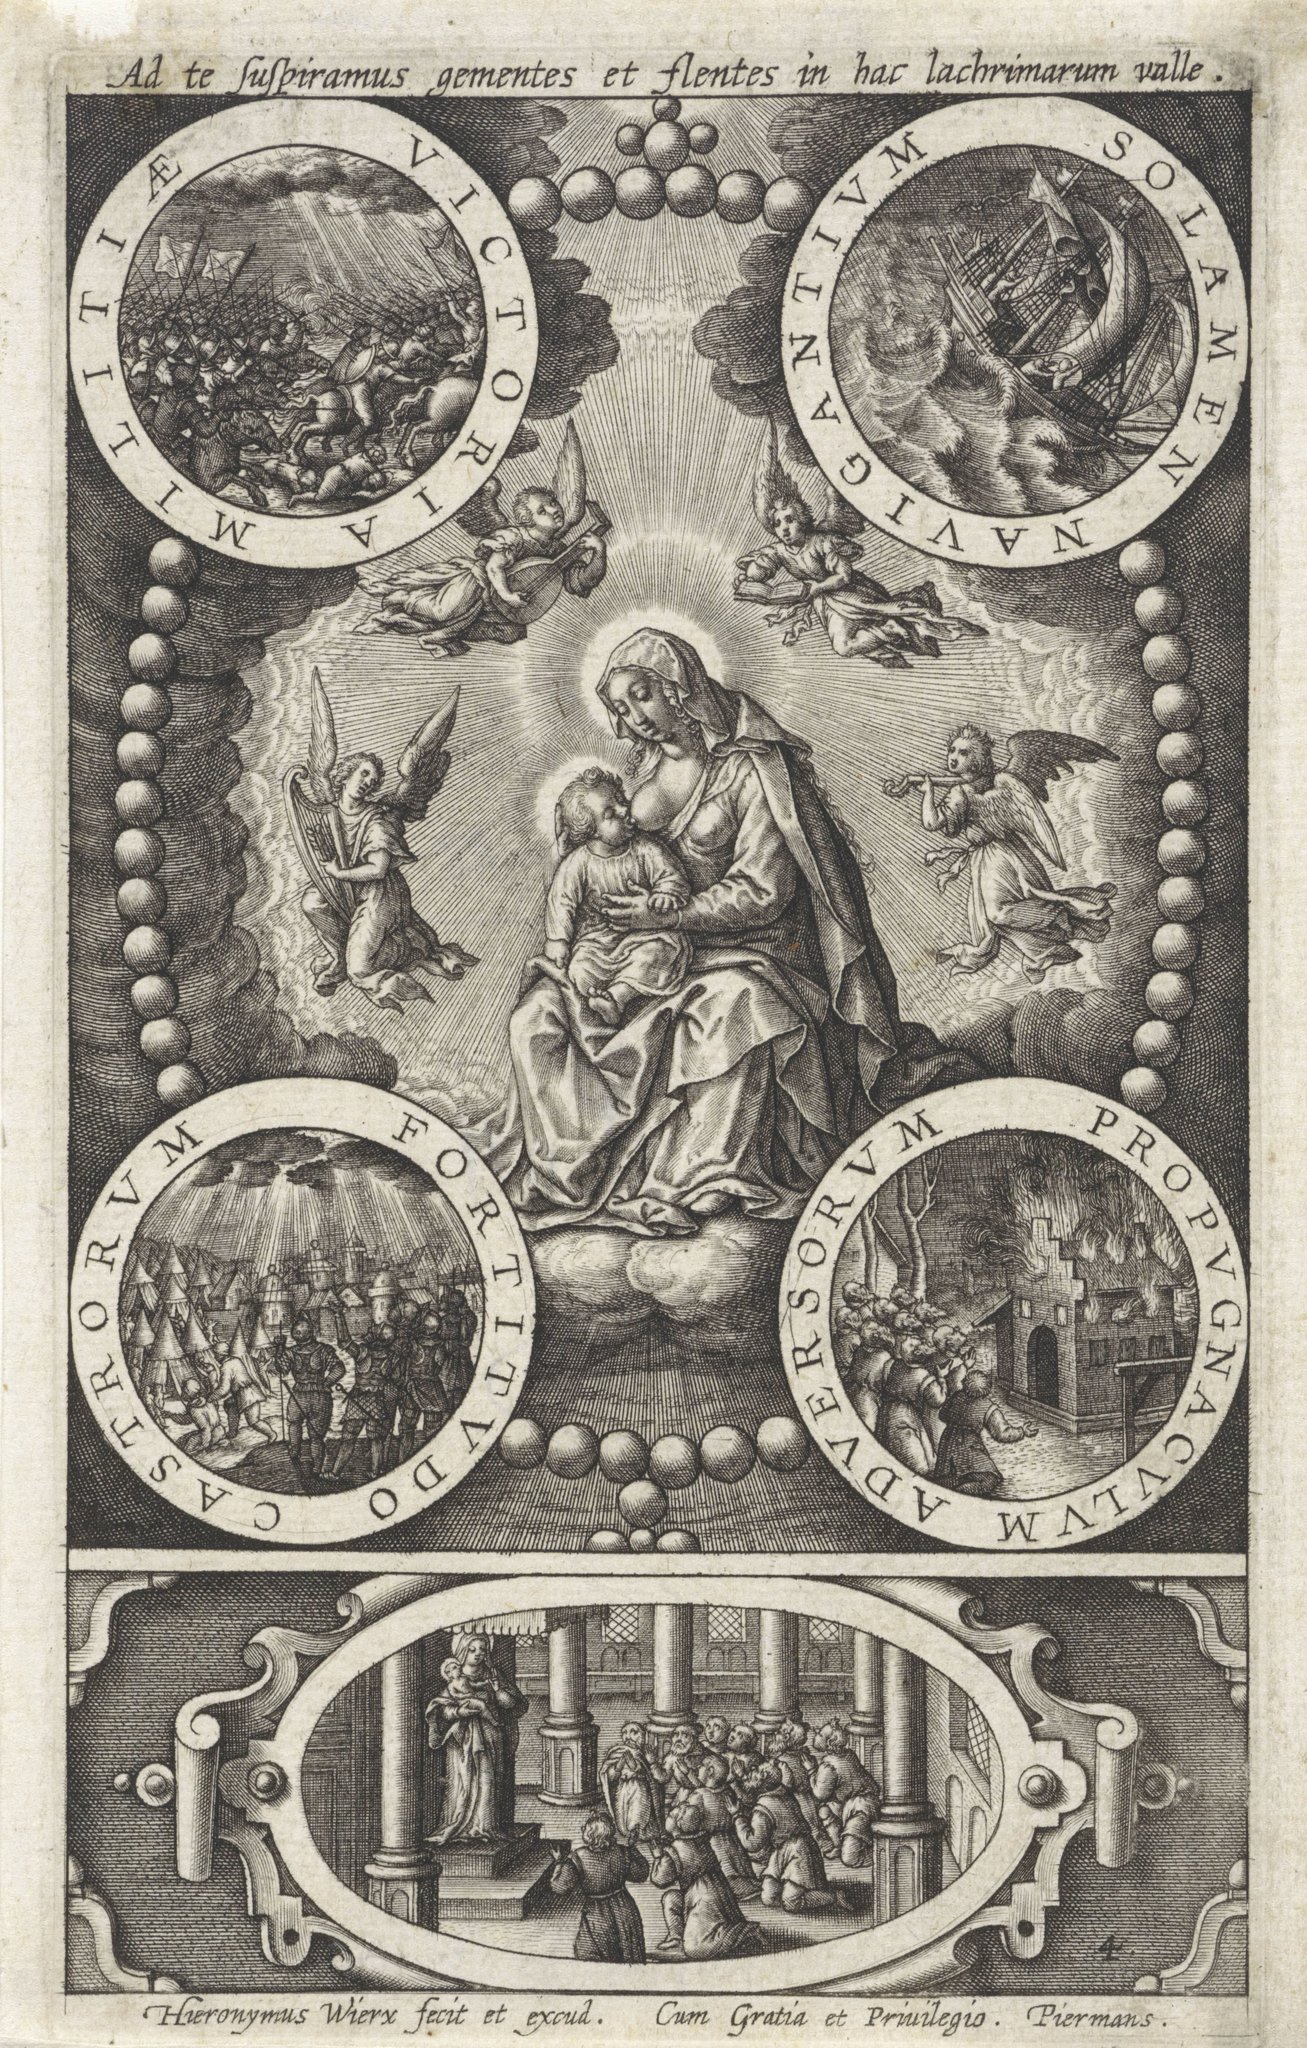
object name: print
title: Maria zoogt het Christuskind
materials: paper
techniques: engraving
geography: antwerp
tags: christ-child suckling, or beginning to suckle, e.g. mary uncovering her breast ~ madonna-representations (+ angel(s)), mary devotion, consoling the sorrowful ~ one of the (seven) spiritual acts of mercy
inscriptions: collector's mark: Lugt 2228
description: Maria zoogt het Christuskind dat bij haar op schoot zit. Ze zijn omringd door musicerende engelen. De voorstelling is gevat in een omlijsting van kralen. In elke hoek een medaillon met scènes van Maria die troost biedt aan de behoeftigen. In de cartouche onderaan bidden de gelovigen tot Maria. De prent heeft een bovenschrift in het Latijn.